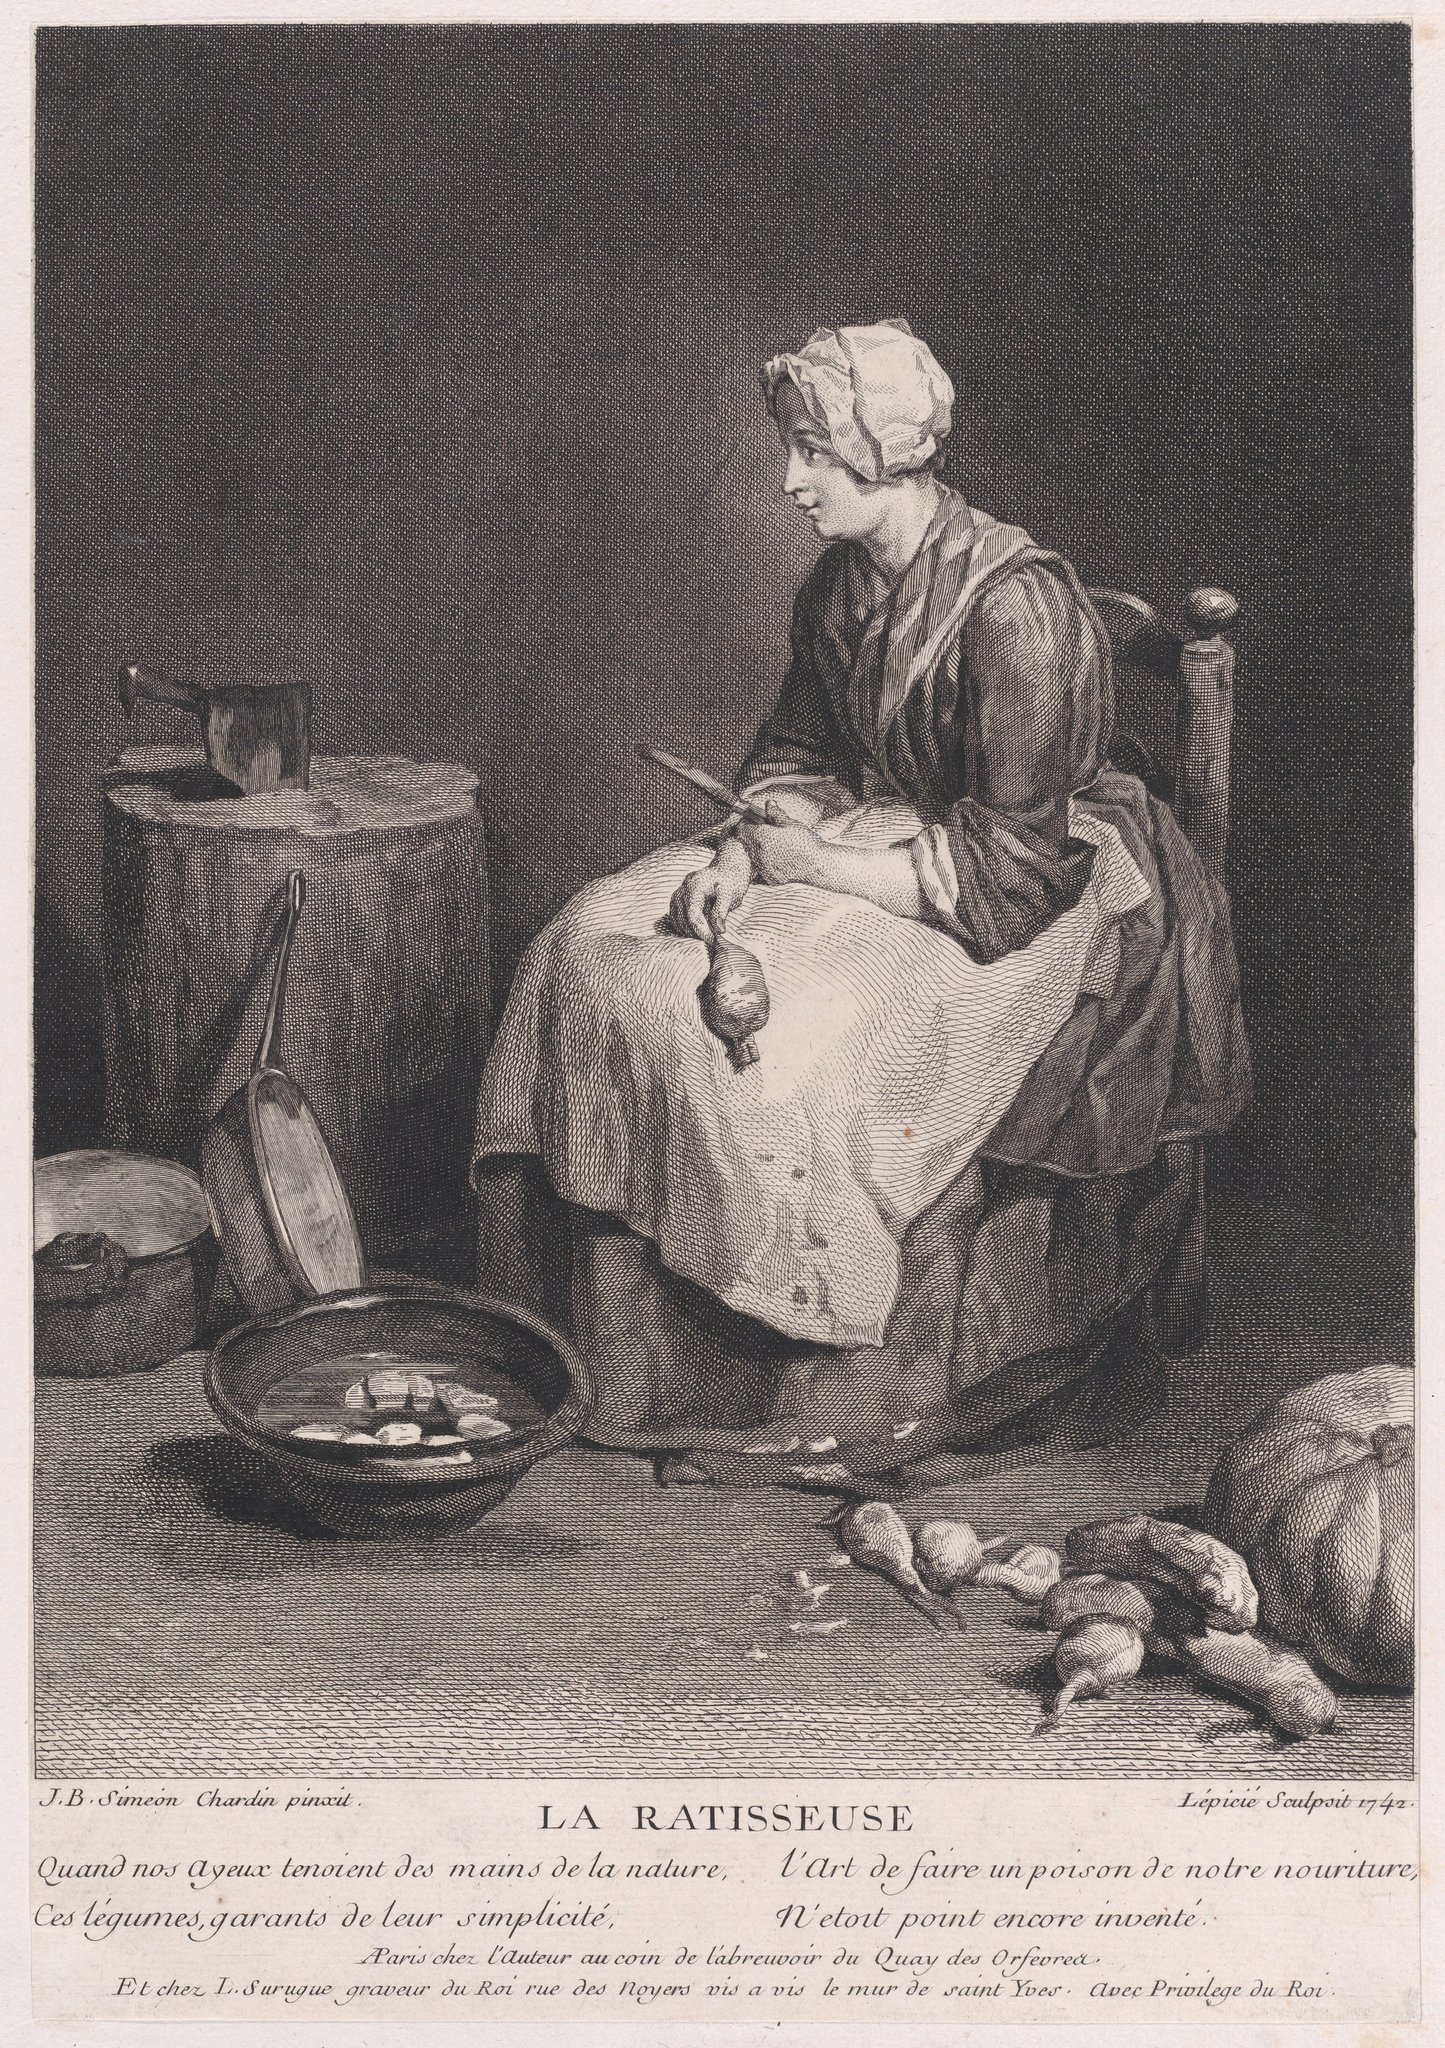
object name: print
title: The Peeler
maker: bernard lepicié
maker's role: artist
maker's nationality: french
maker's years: 1698-1755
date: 1742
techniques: engraving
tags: food,vegetables,women